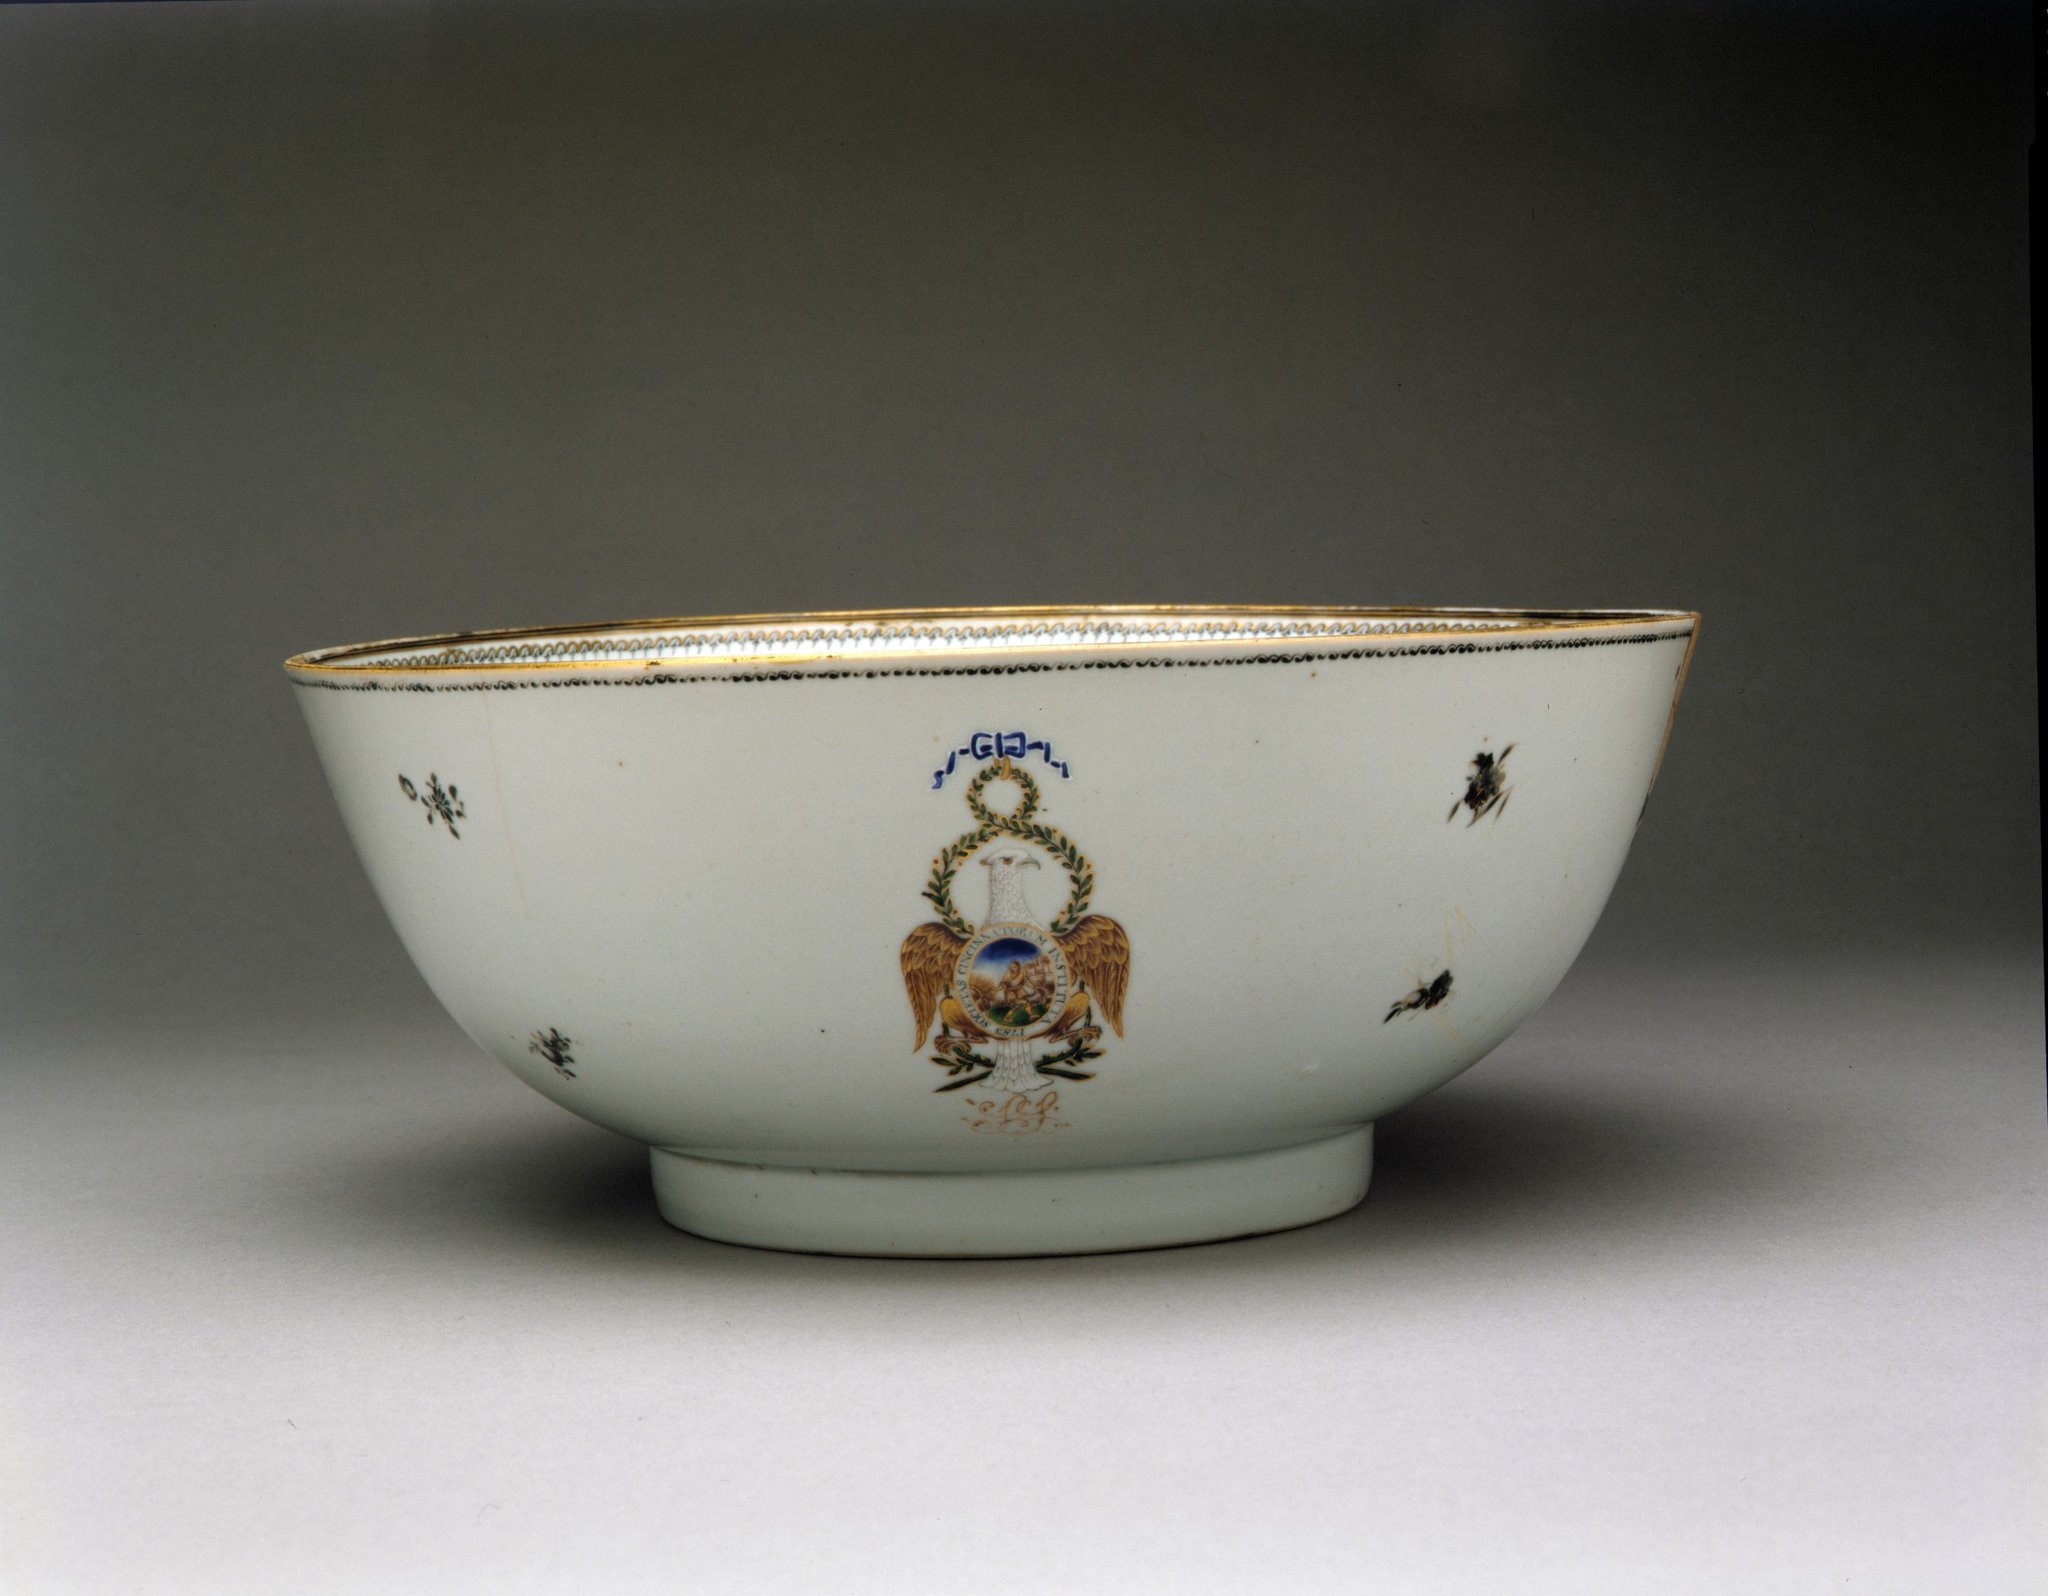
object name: bowl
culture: chinese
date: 1770-1800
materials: porcelain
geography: china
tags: eagles,coat of arms